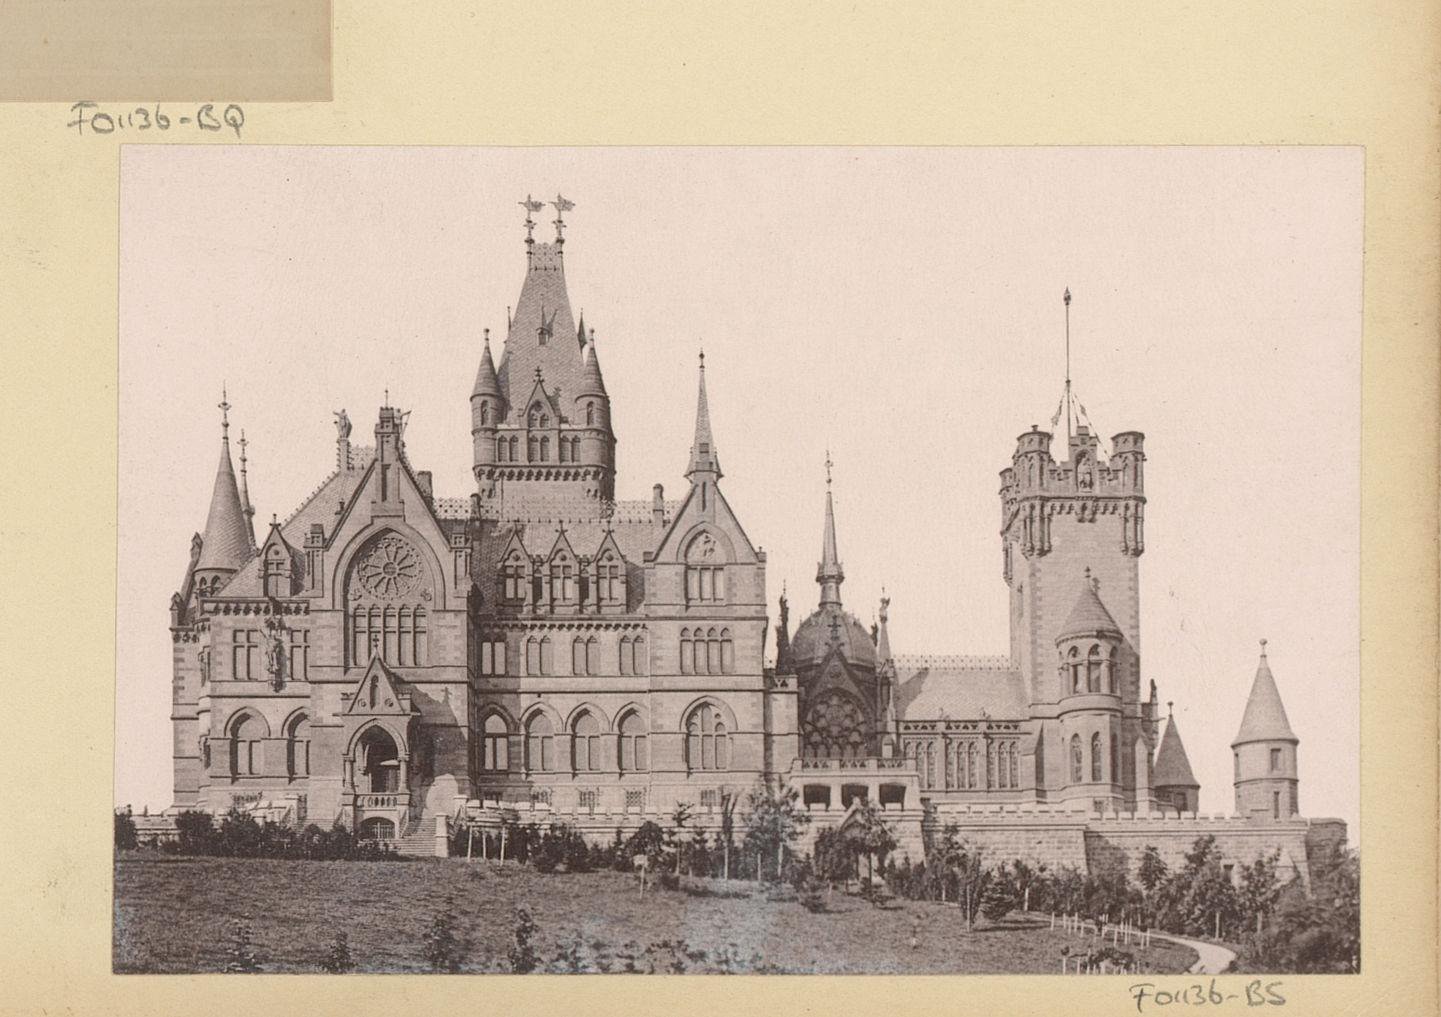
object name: photomechanical print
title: Exterieur van Schloss Drachenburg in Königswinter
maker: Anonymous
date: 1880-1895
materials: paper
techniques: photograph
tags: castle, palace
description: Onderdeel van Fotoalbum met opnames van bezienswaardigheden in België, Duitsland en Noorwegen.